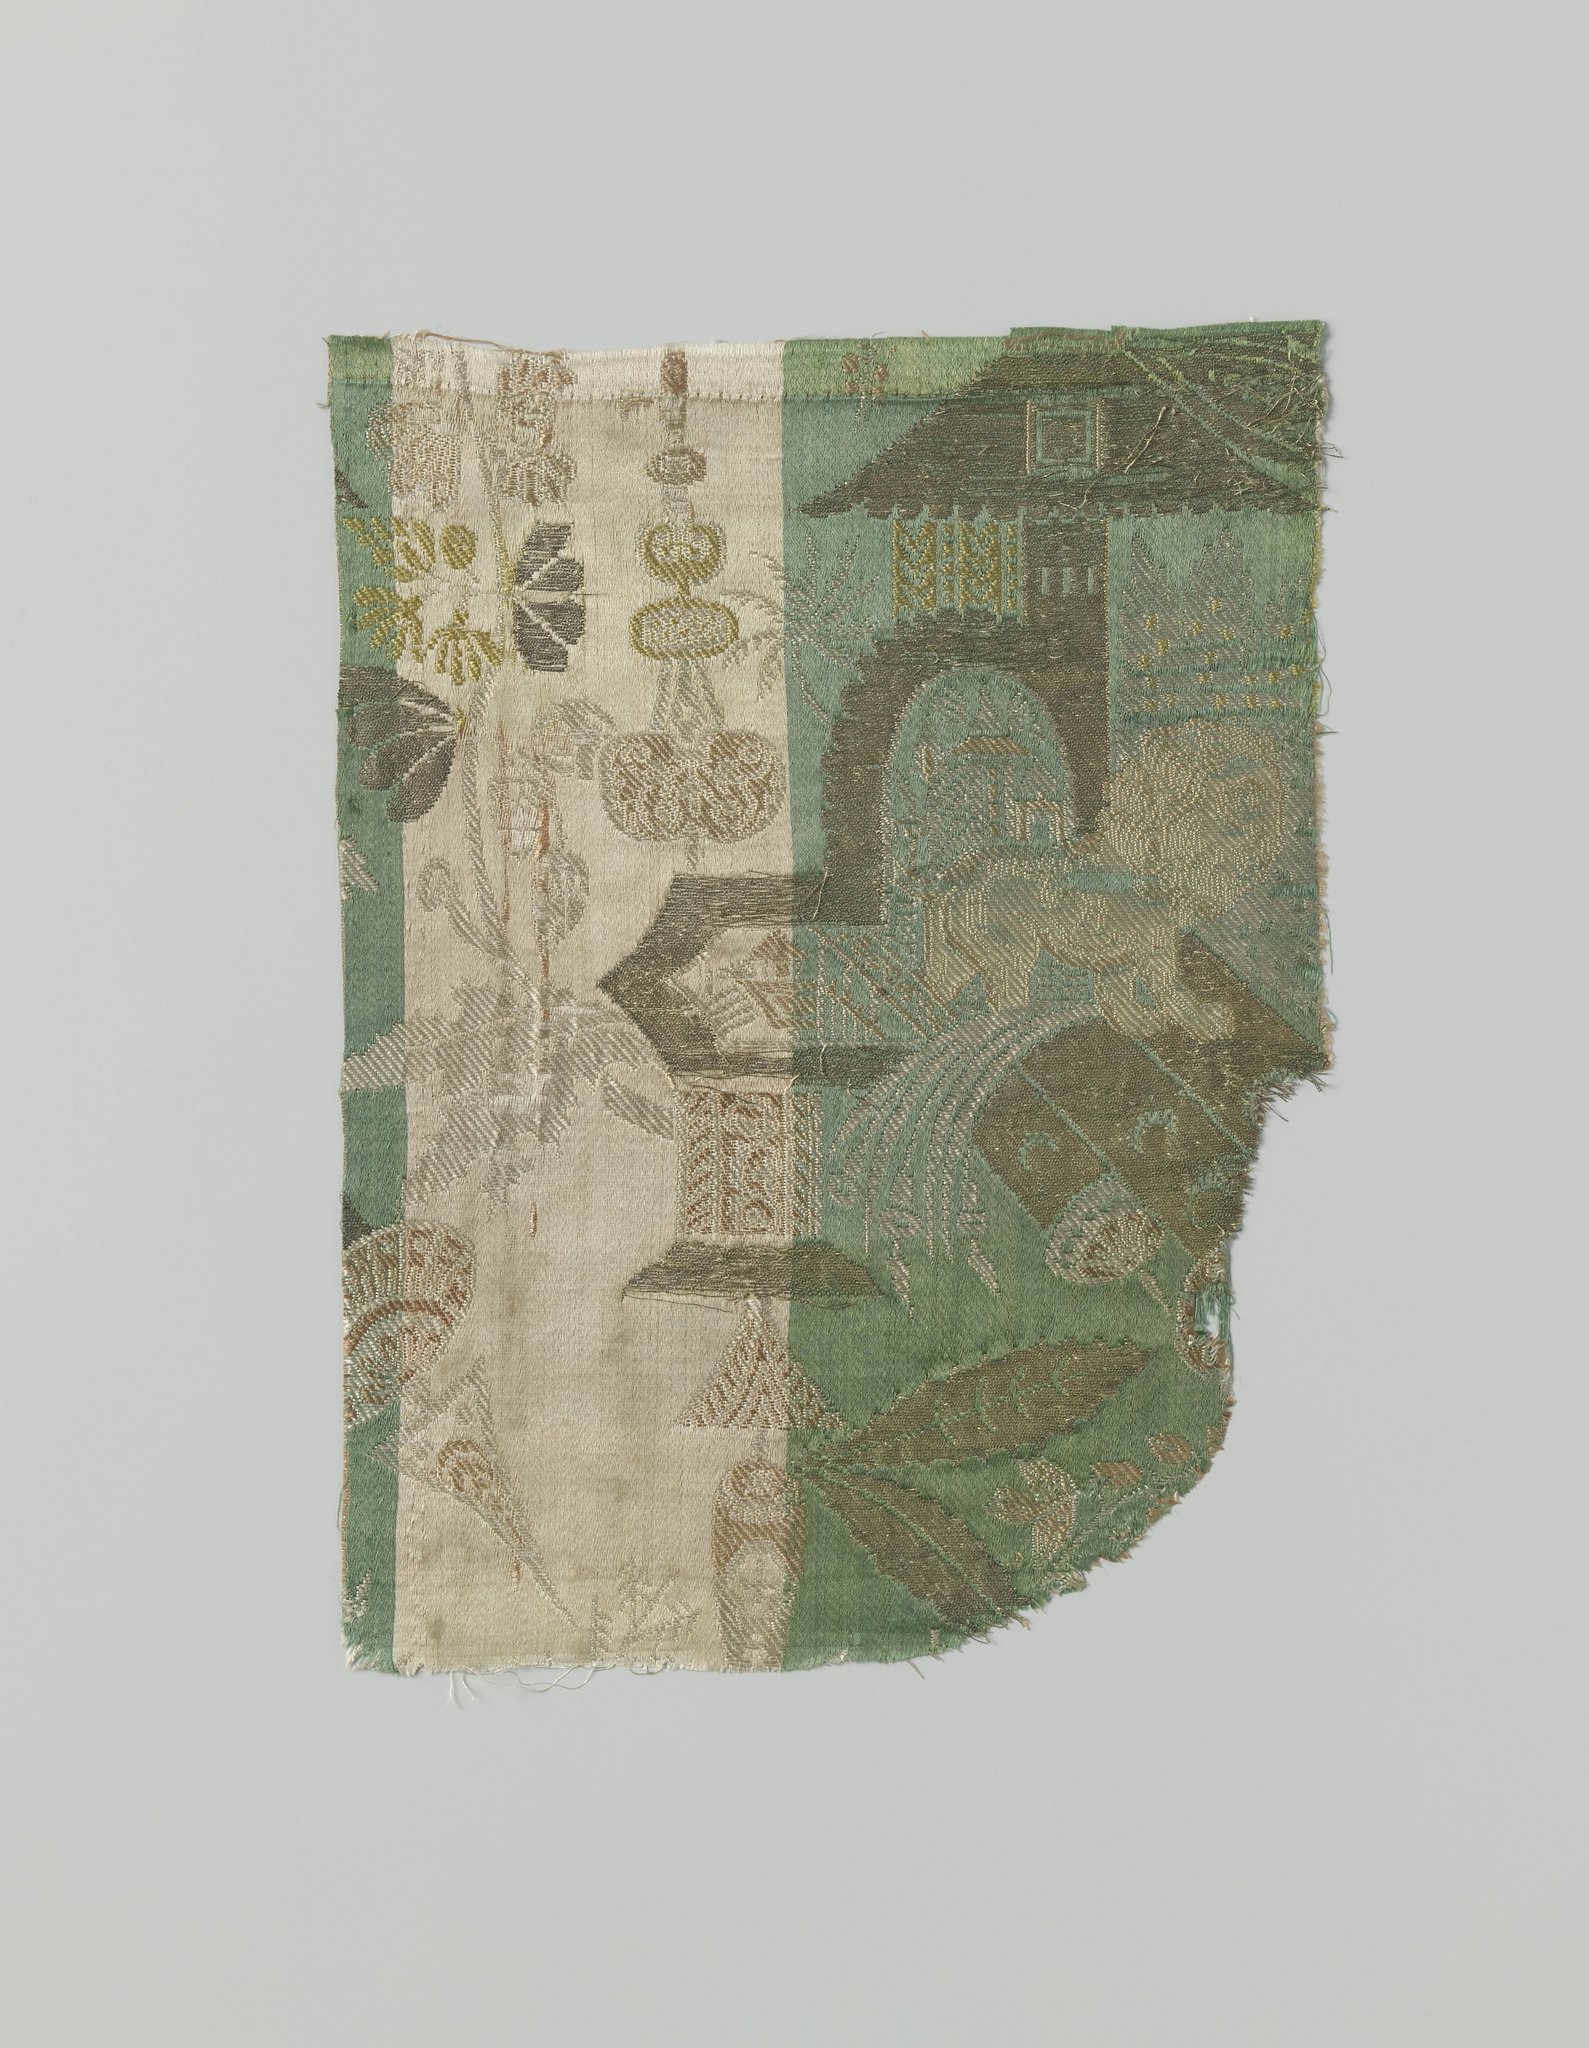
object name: woven material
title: Fragment bizarre zijde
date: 1704-1709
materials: silk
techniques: brocade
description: Fragmente bizarre zijde. Fond van satijn in groene en beige strepen, waarop een een patroon van bladeren, een parasol, Chinese architectuur met een pagoda-vormig gebouw met een poort waarin een leeuw. (Patroon identiek aan BK-BR-416-A)